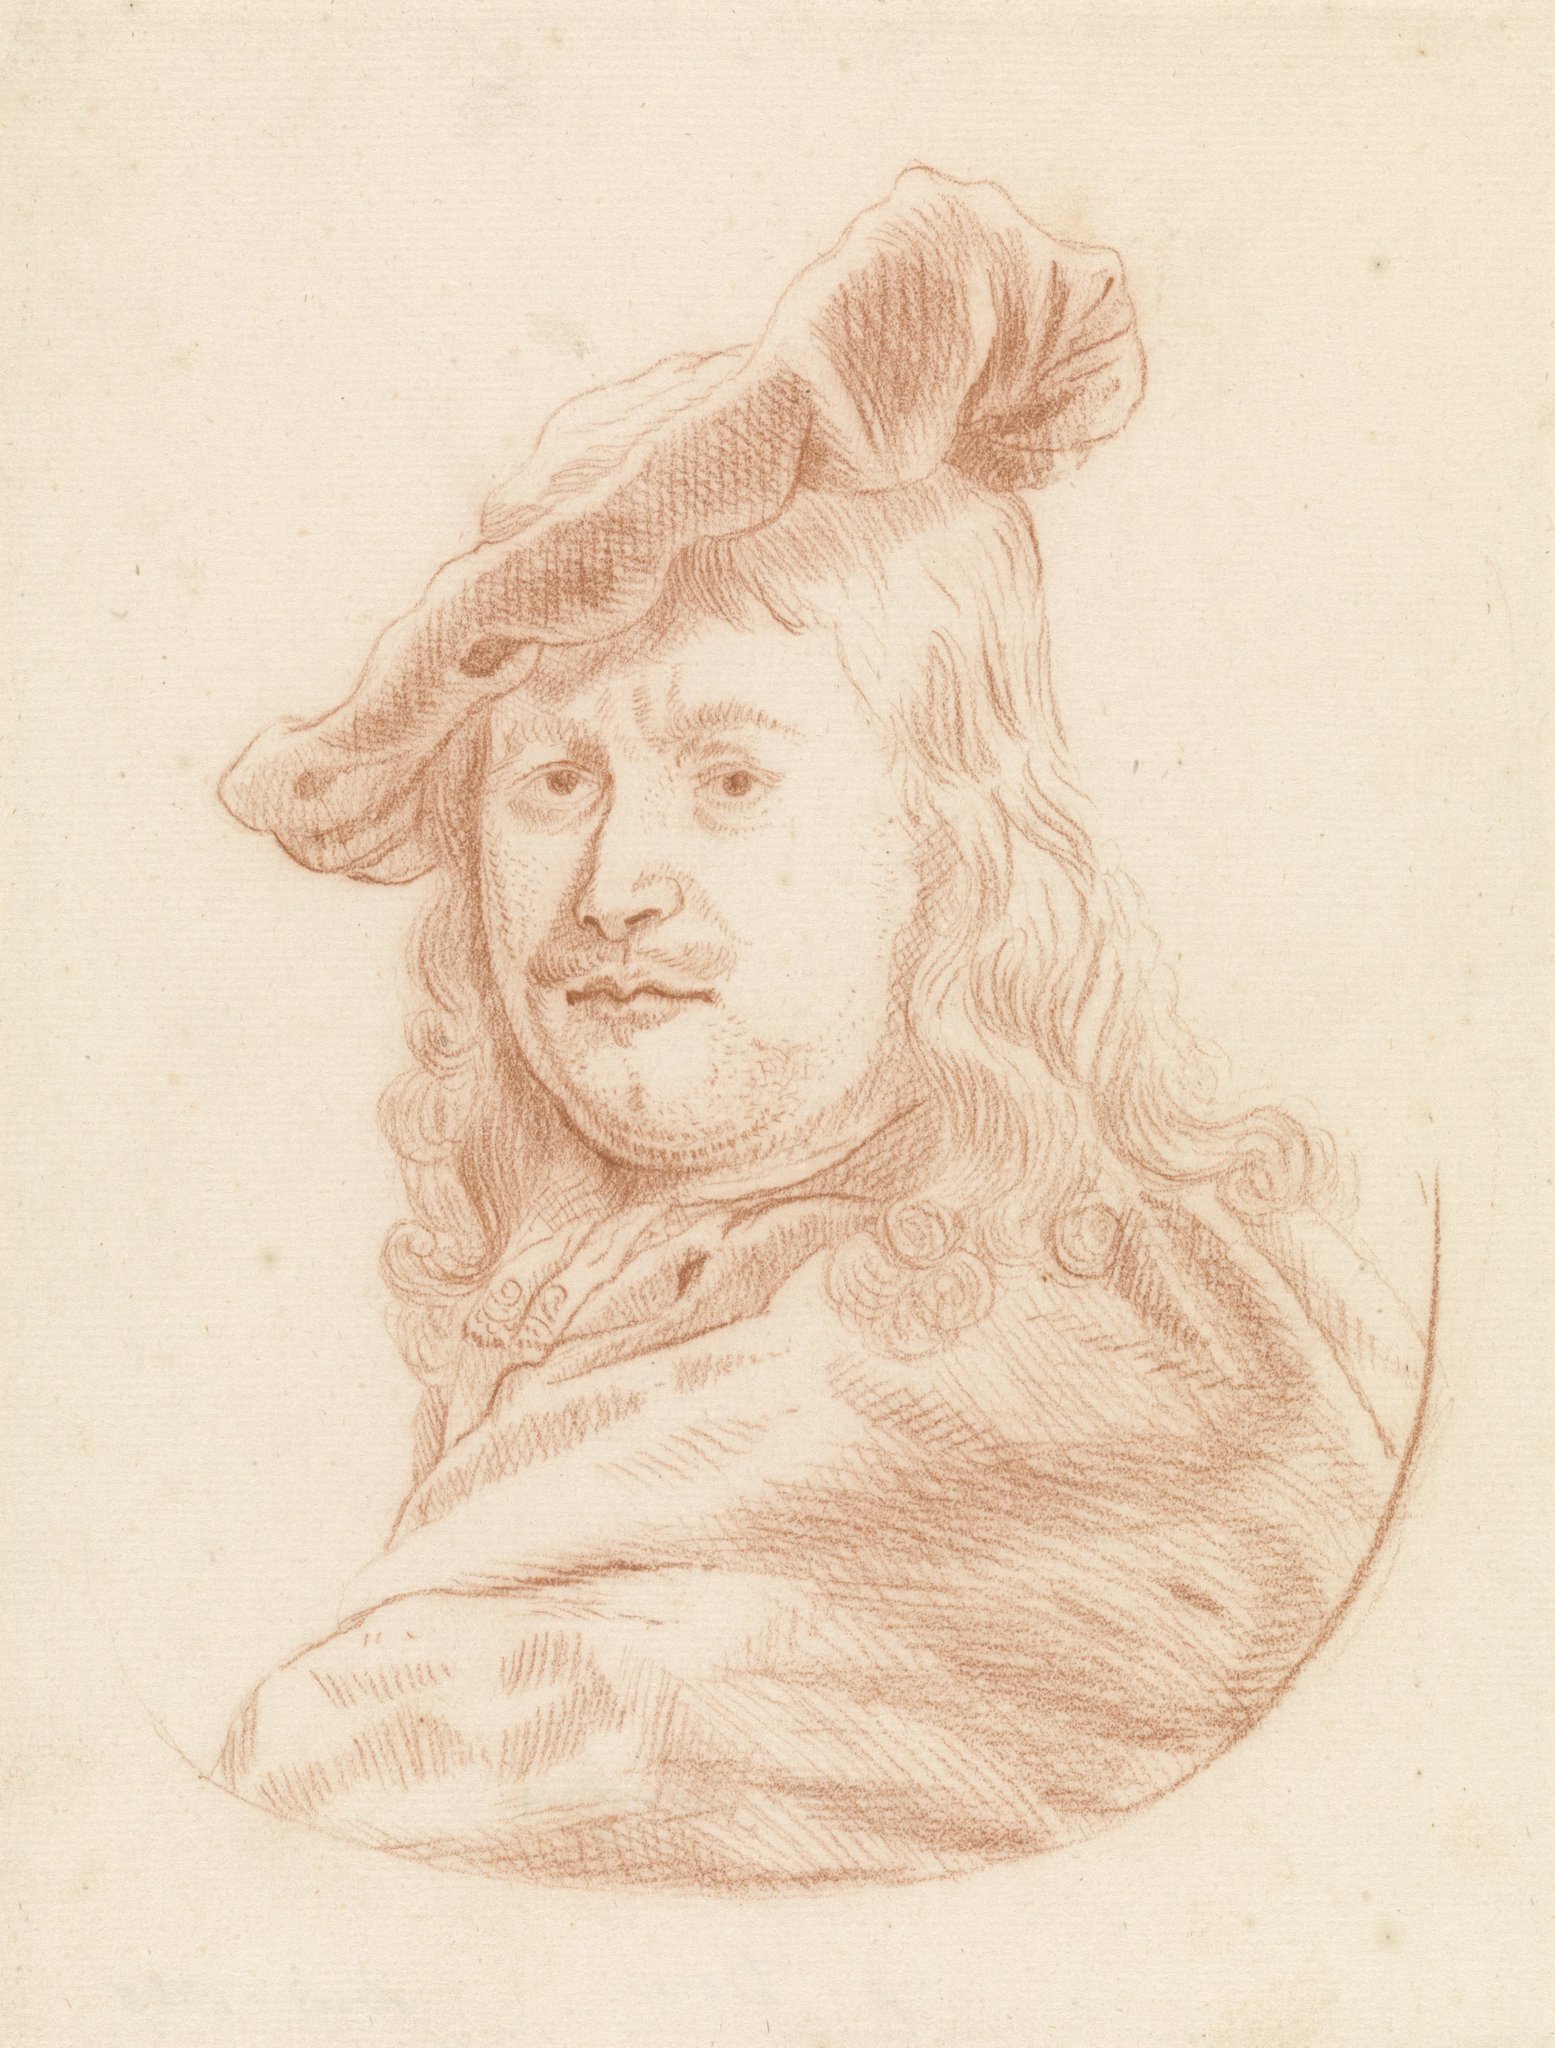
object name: drawing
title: Portret van Gerard Dou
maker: Anonymous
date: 1700-1725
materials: chalk, paper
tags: leiden, gerard dou, historical persons, portrait, self-portrait of painter, portrait, self-portrait of artist, portrait, self-portrait of draughtsman